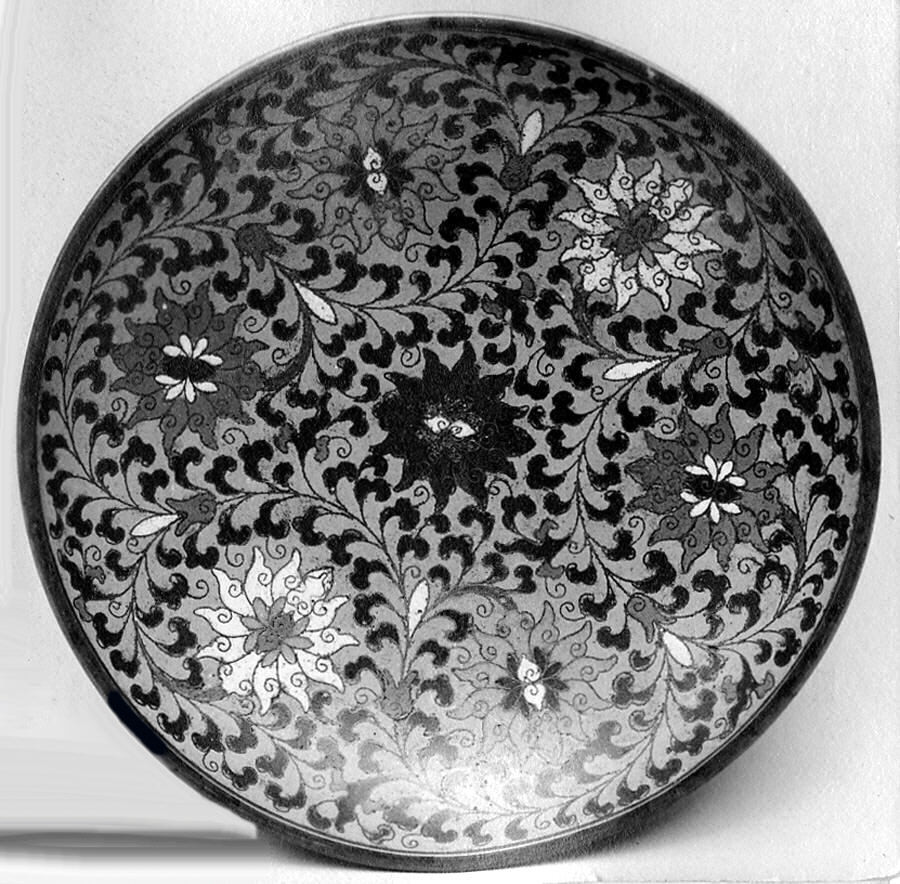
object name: dish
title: Dish with Stylized Flowers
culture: chinese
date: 1567-1633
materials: enamel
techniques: enamel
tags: flowers